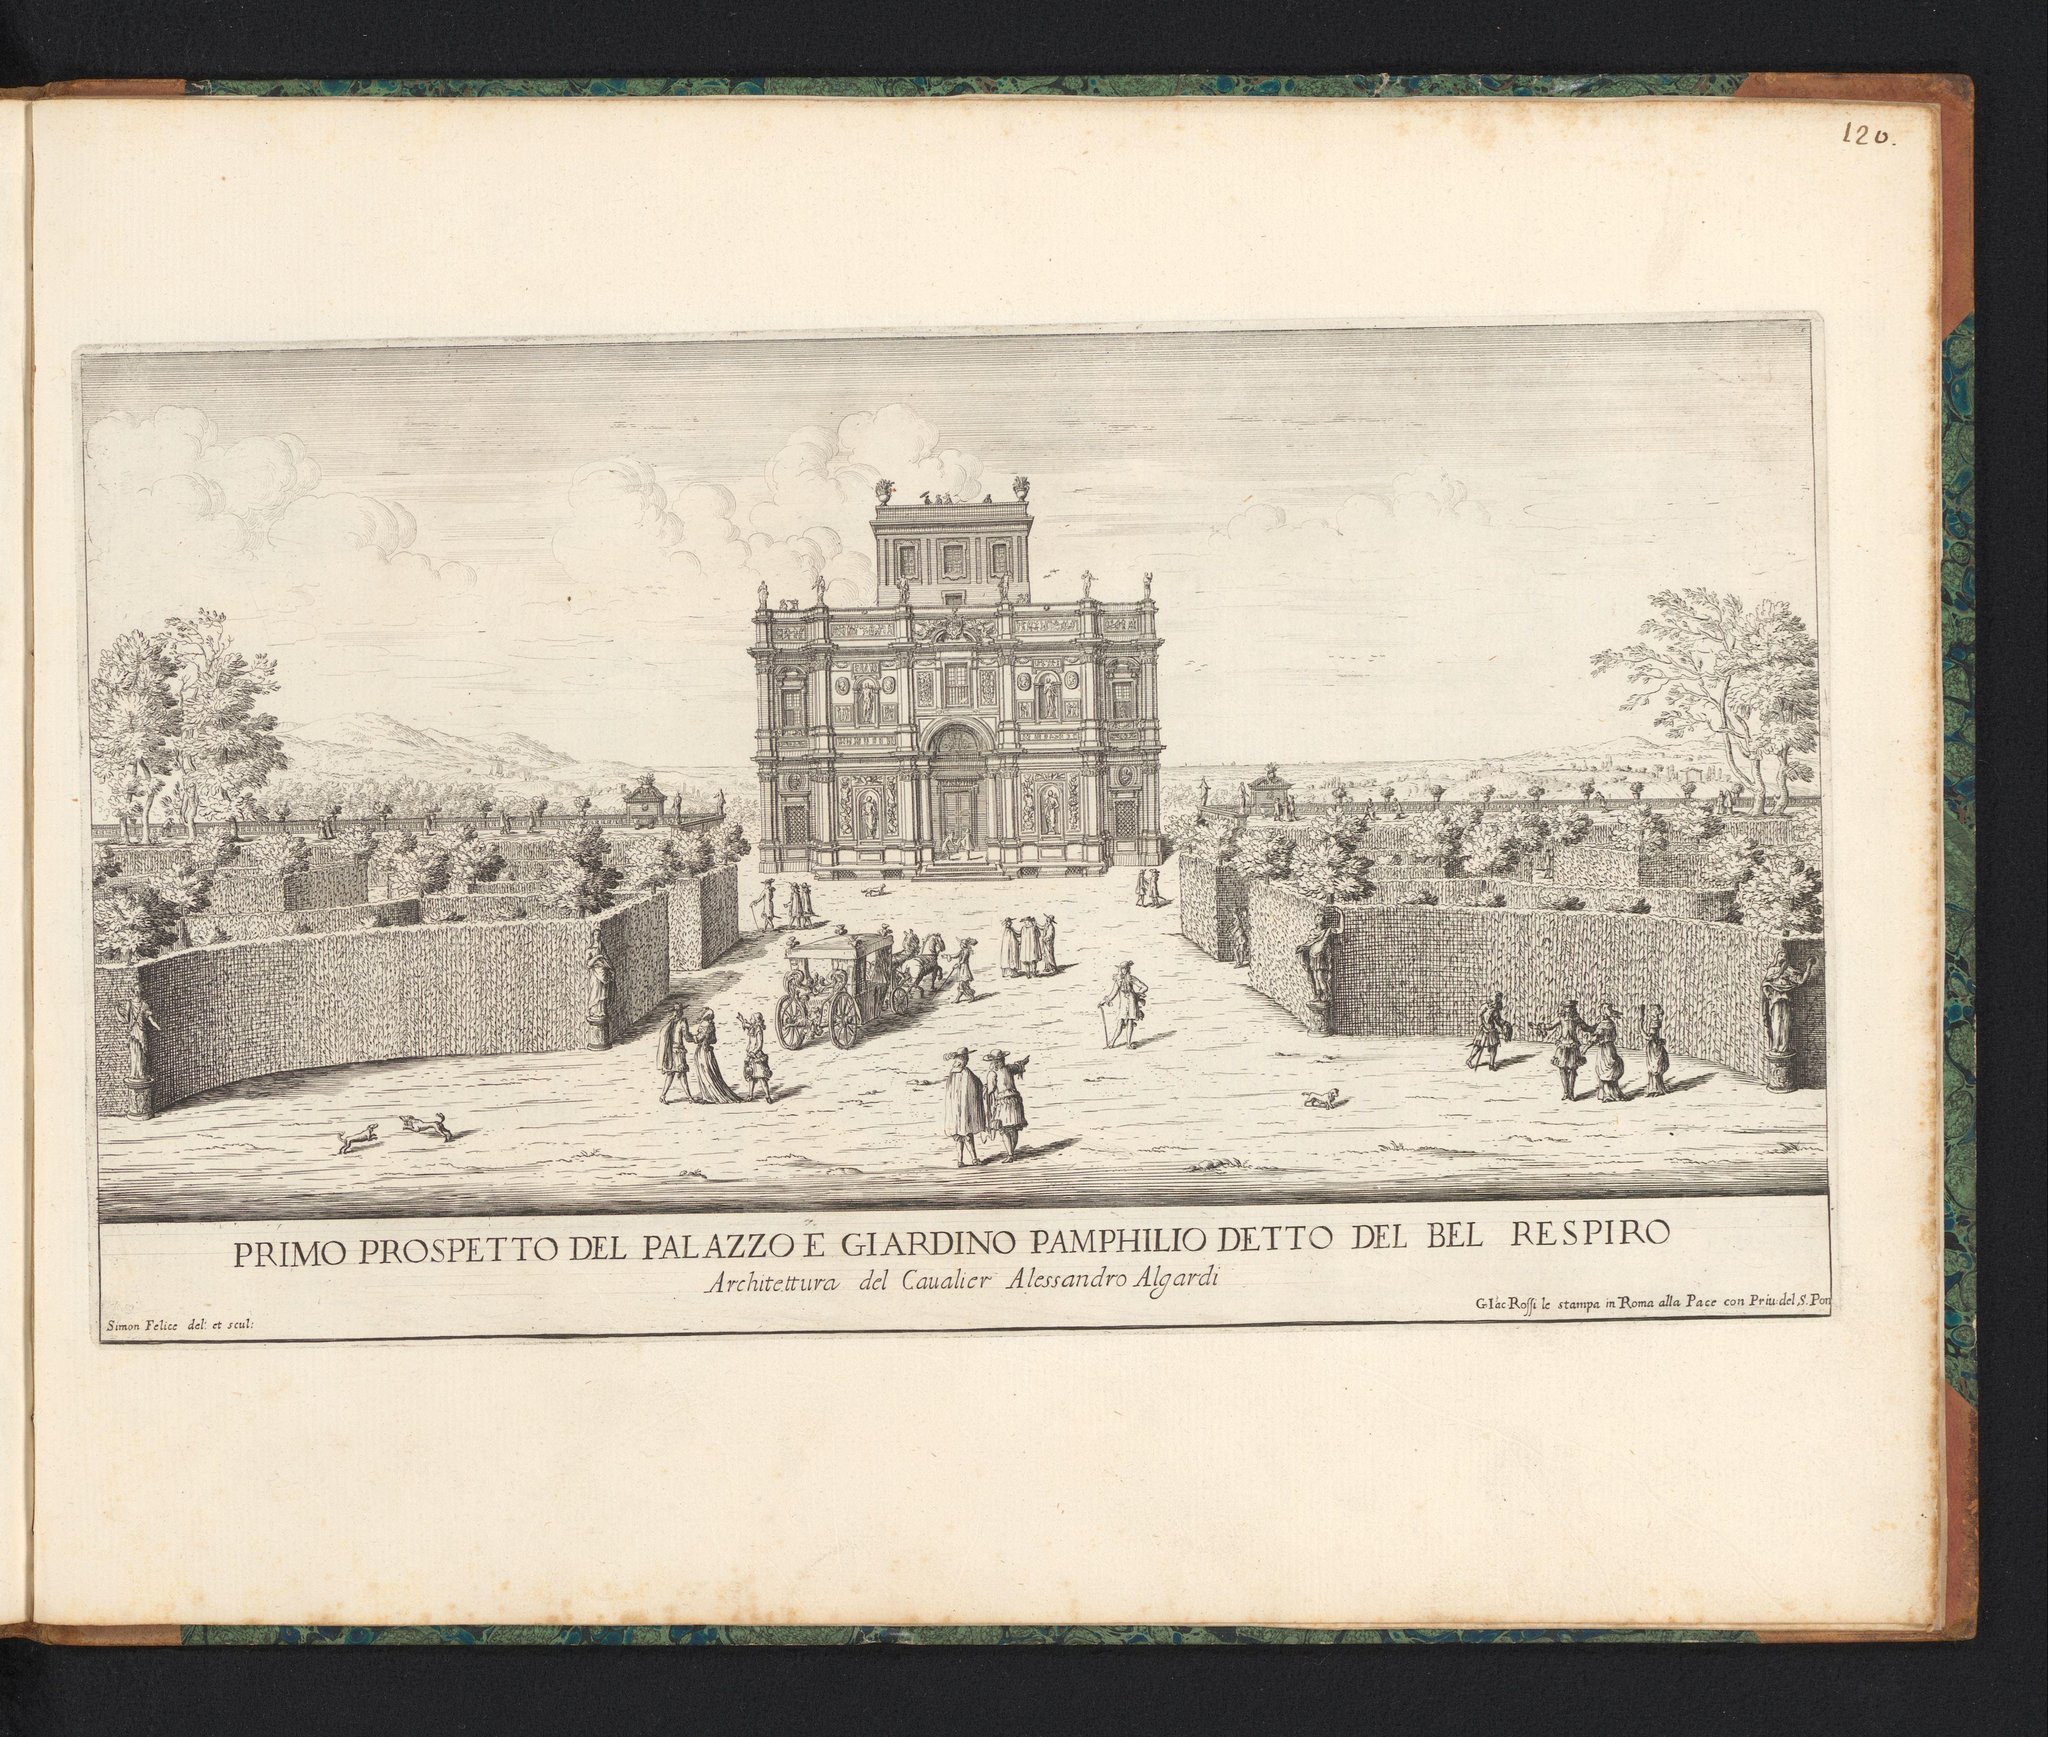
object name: print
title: Gezicht op de Villa Doria Pamphilj en tuinen te Rome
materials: paper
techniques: etching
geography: italy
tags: plan, map of garden, garden, hôtel, i.e. small palace in city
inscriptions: number: ‘120’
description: Gezicht op de Villa Doria Pamphilj en tuinen te Rome. In de ondermarge de titel. Prent maakt deel uit van een album.